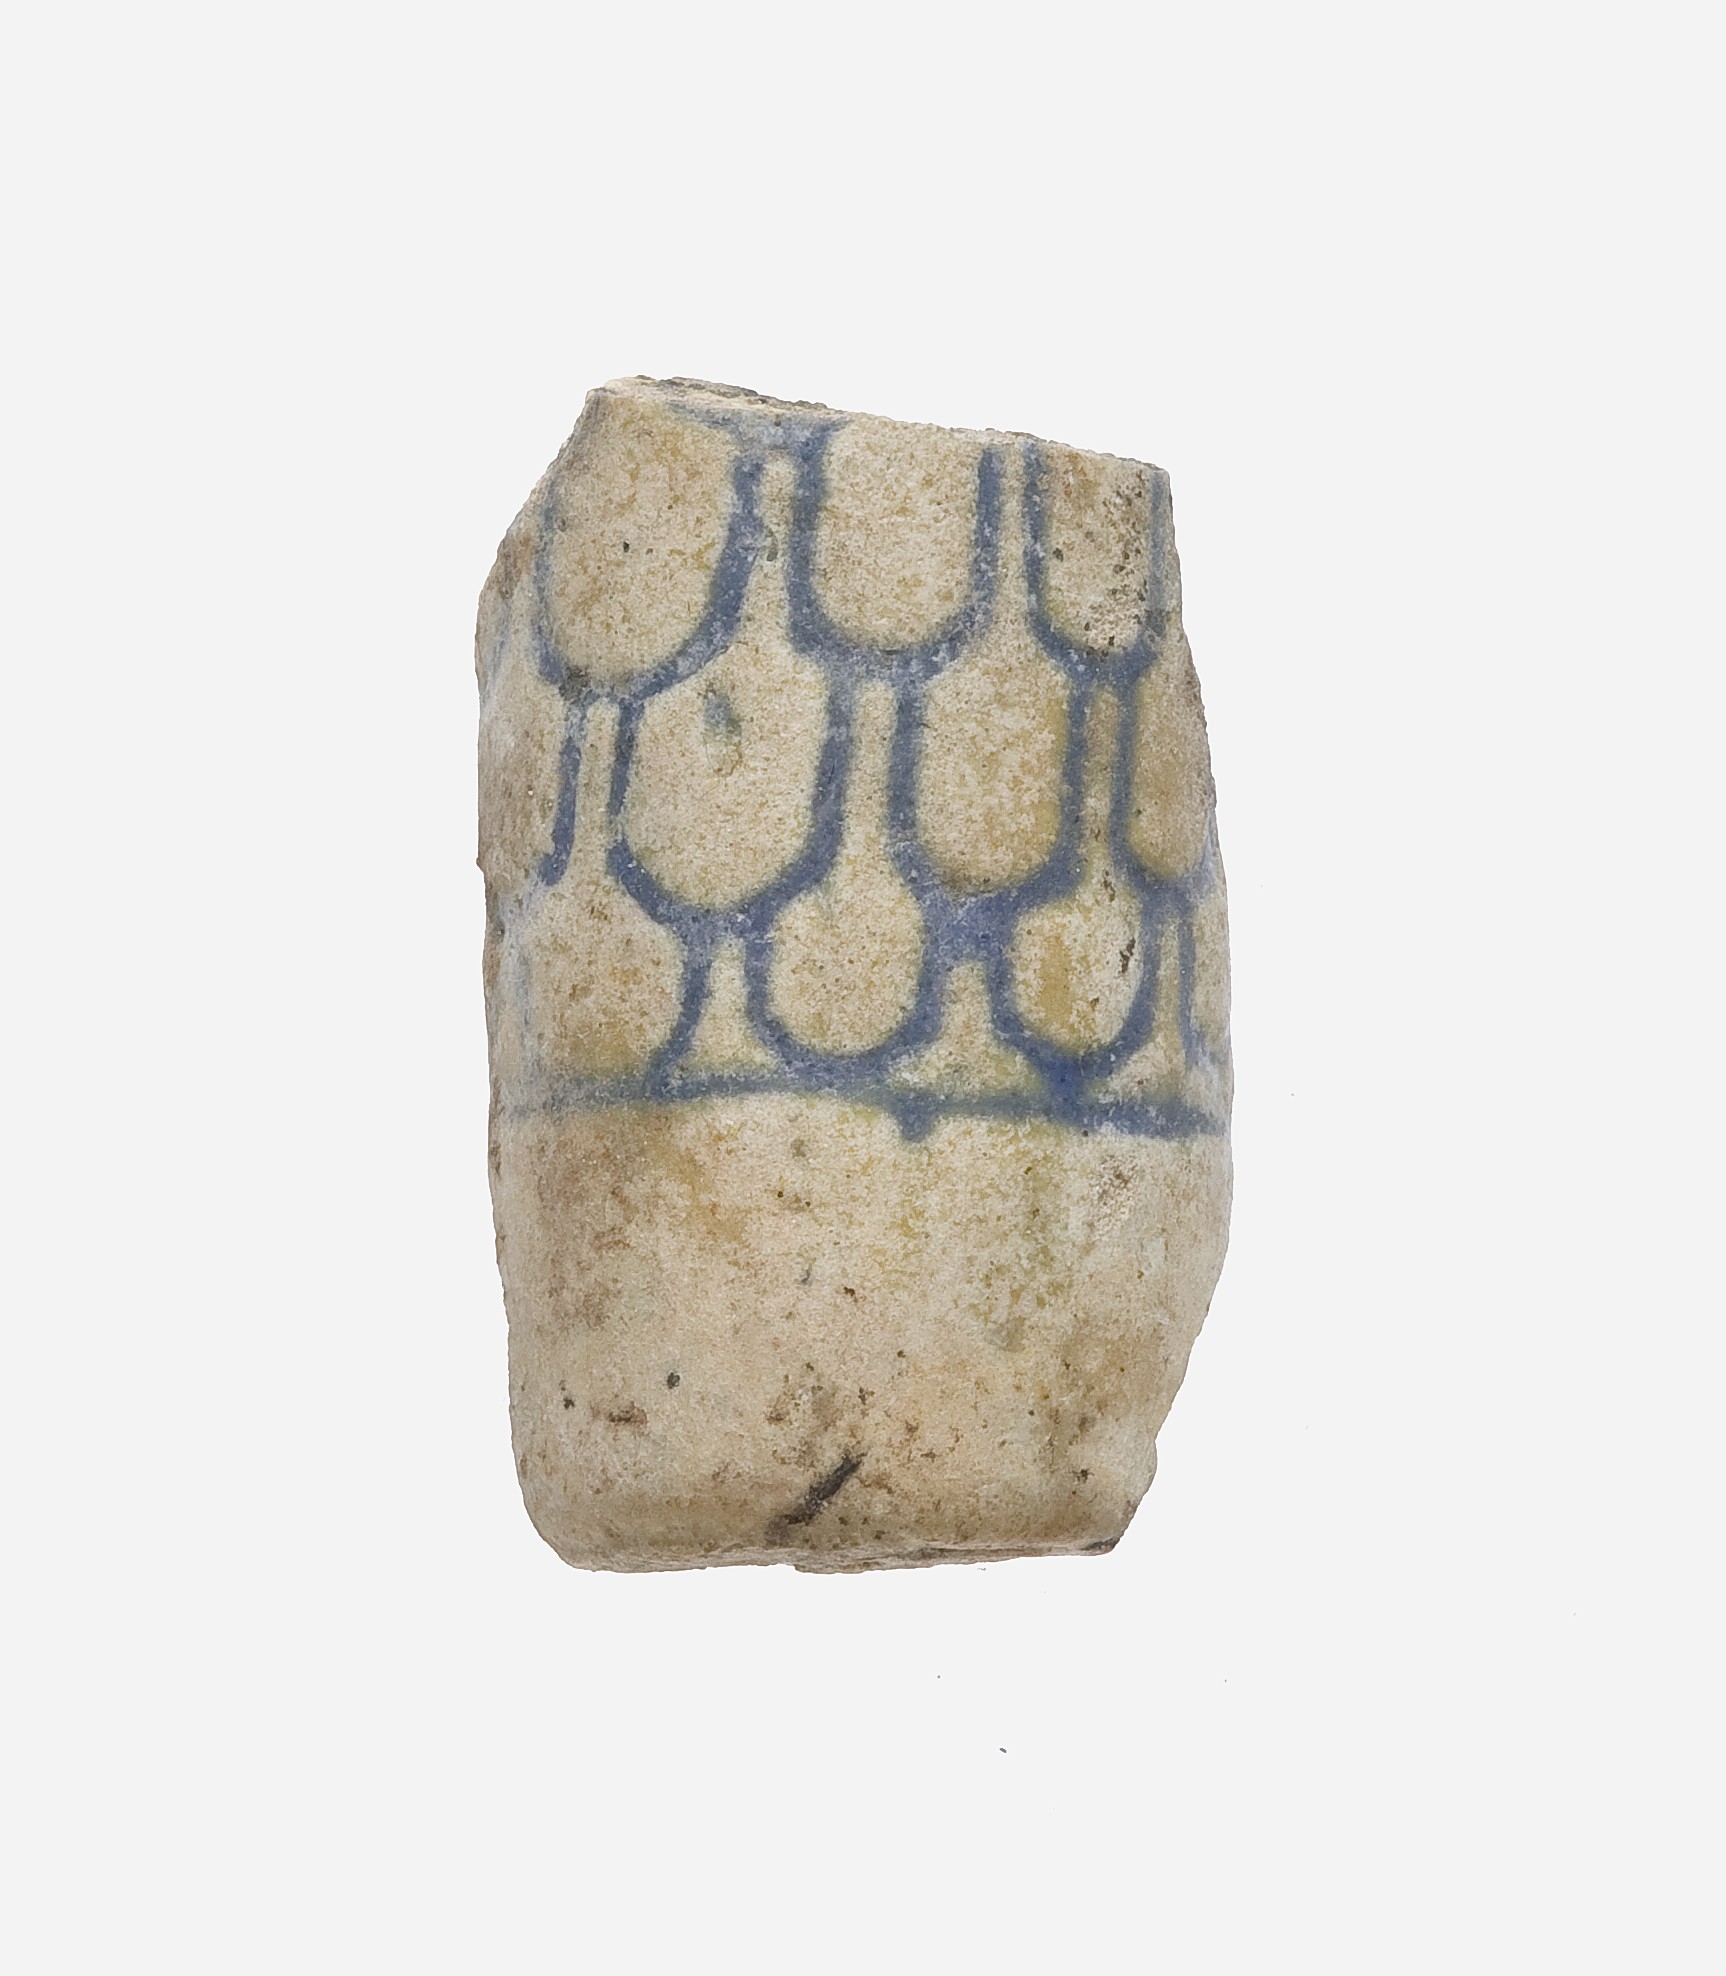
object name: kohl tube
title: Bottom of Kohl Tube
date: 1390-1352 BCE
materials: faience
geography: egypt